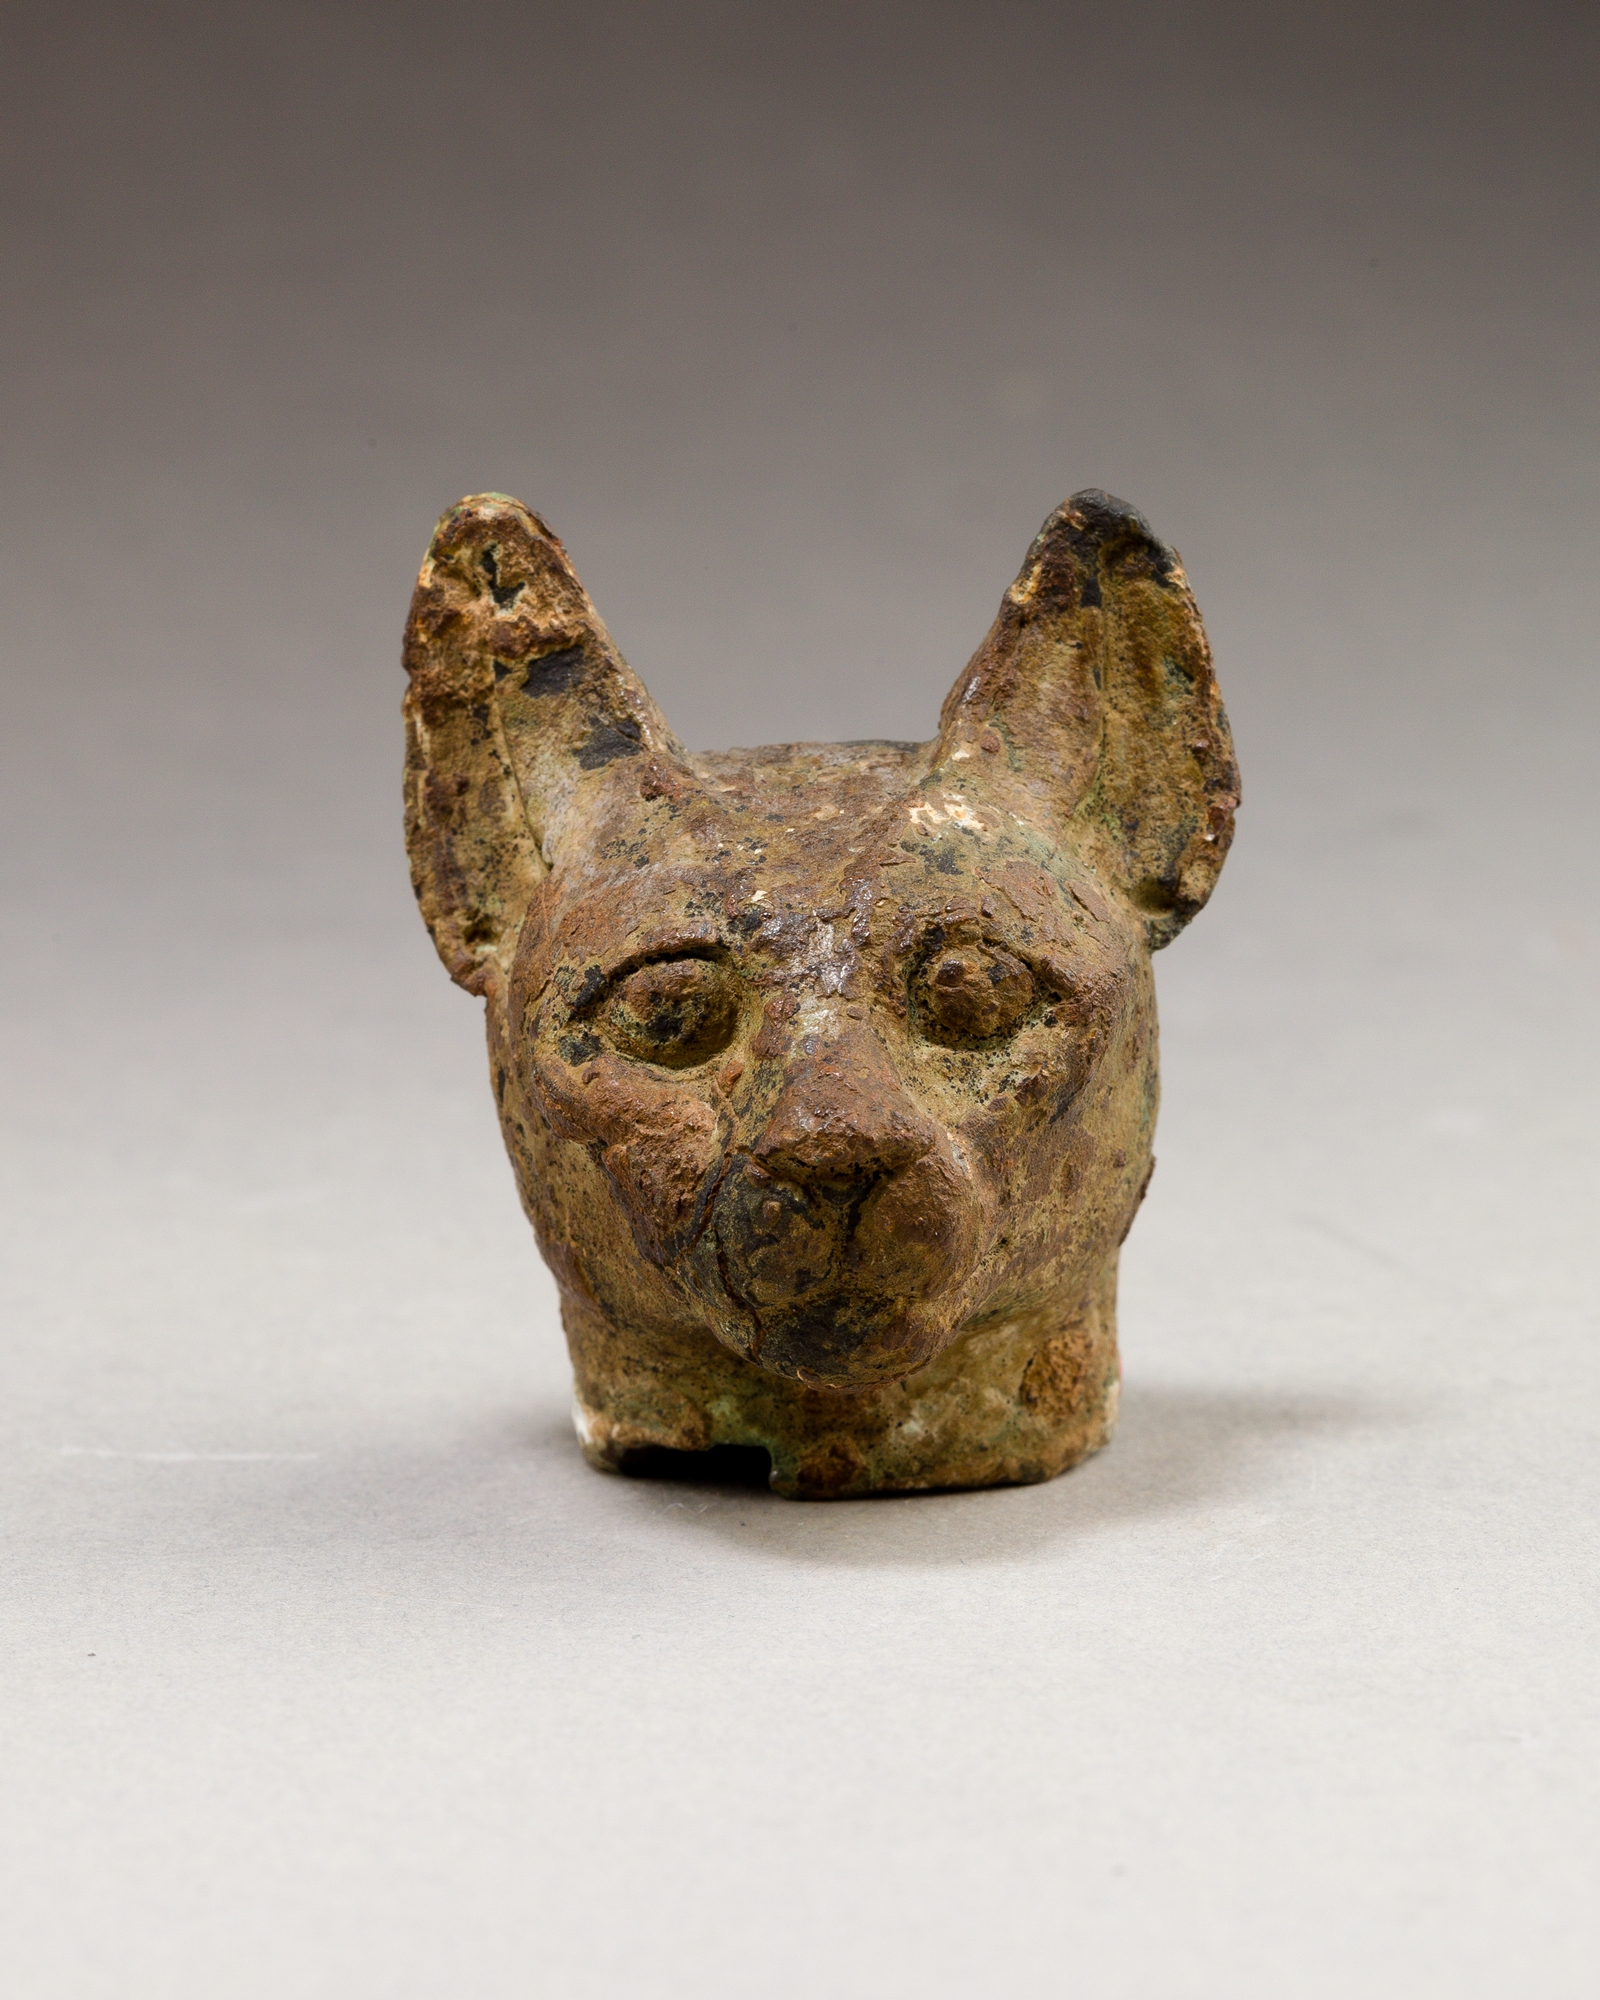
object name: figurine, cat head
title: Cat head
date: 664-630 BCE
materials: metal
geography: egypt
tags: goddess